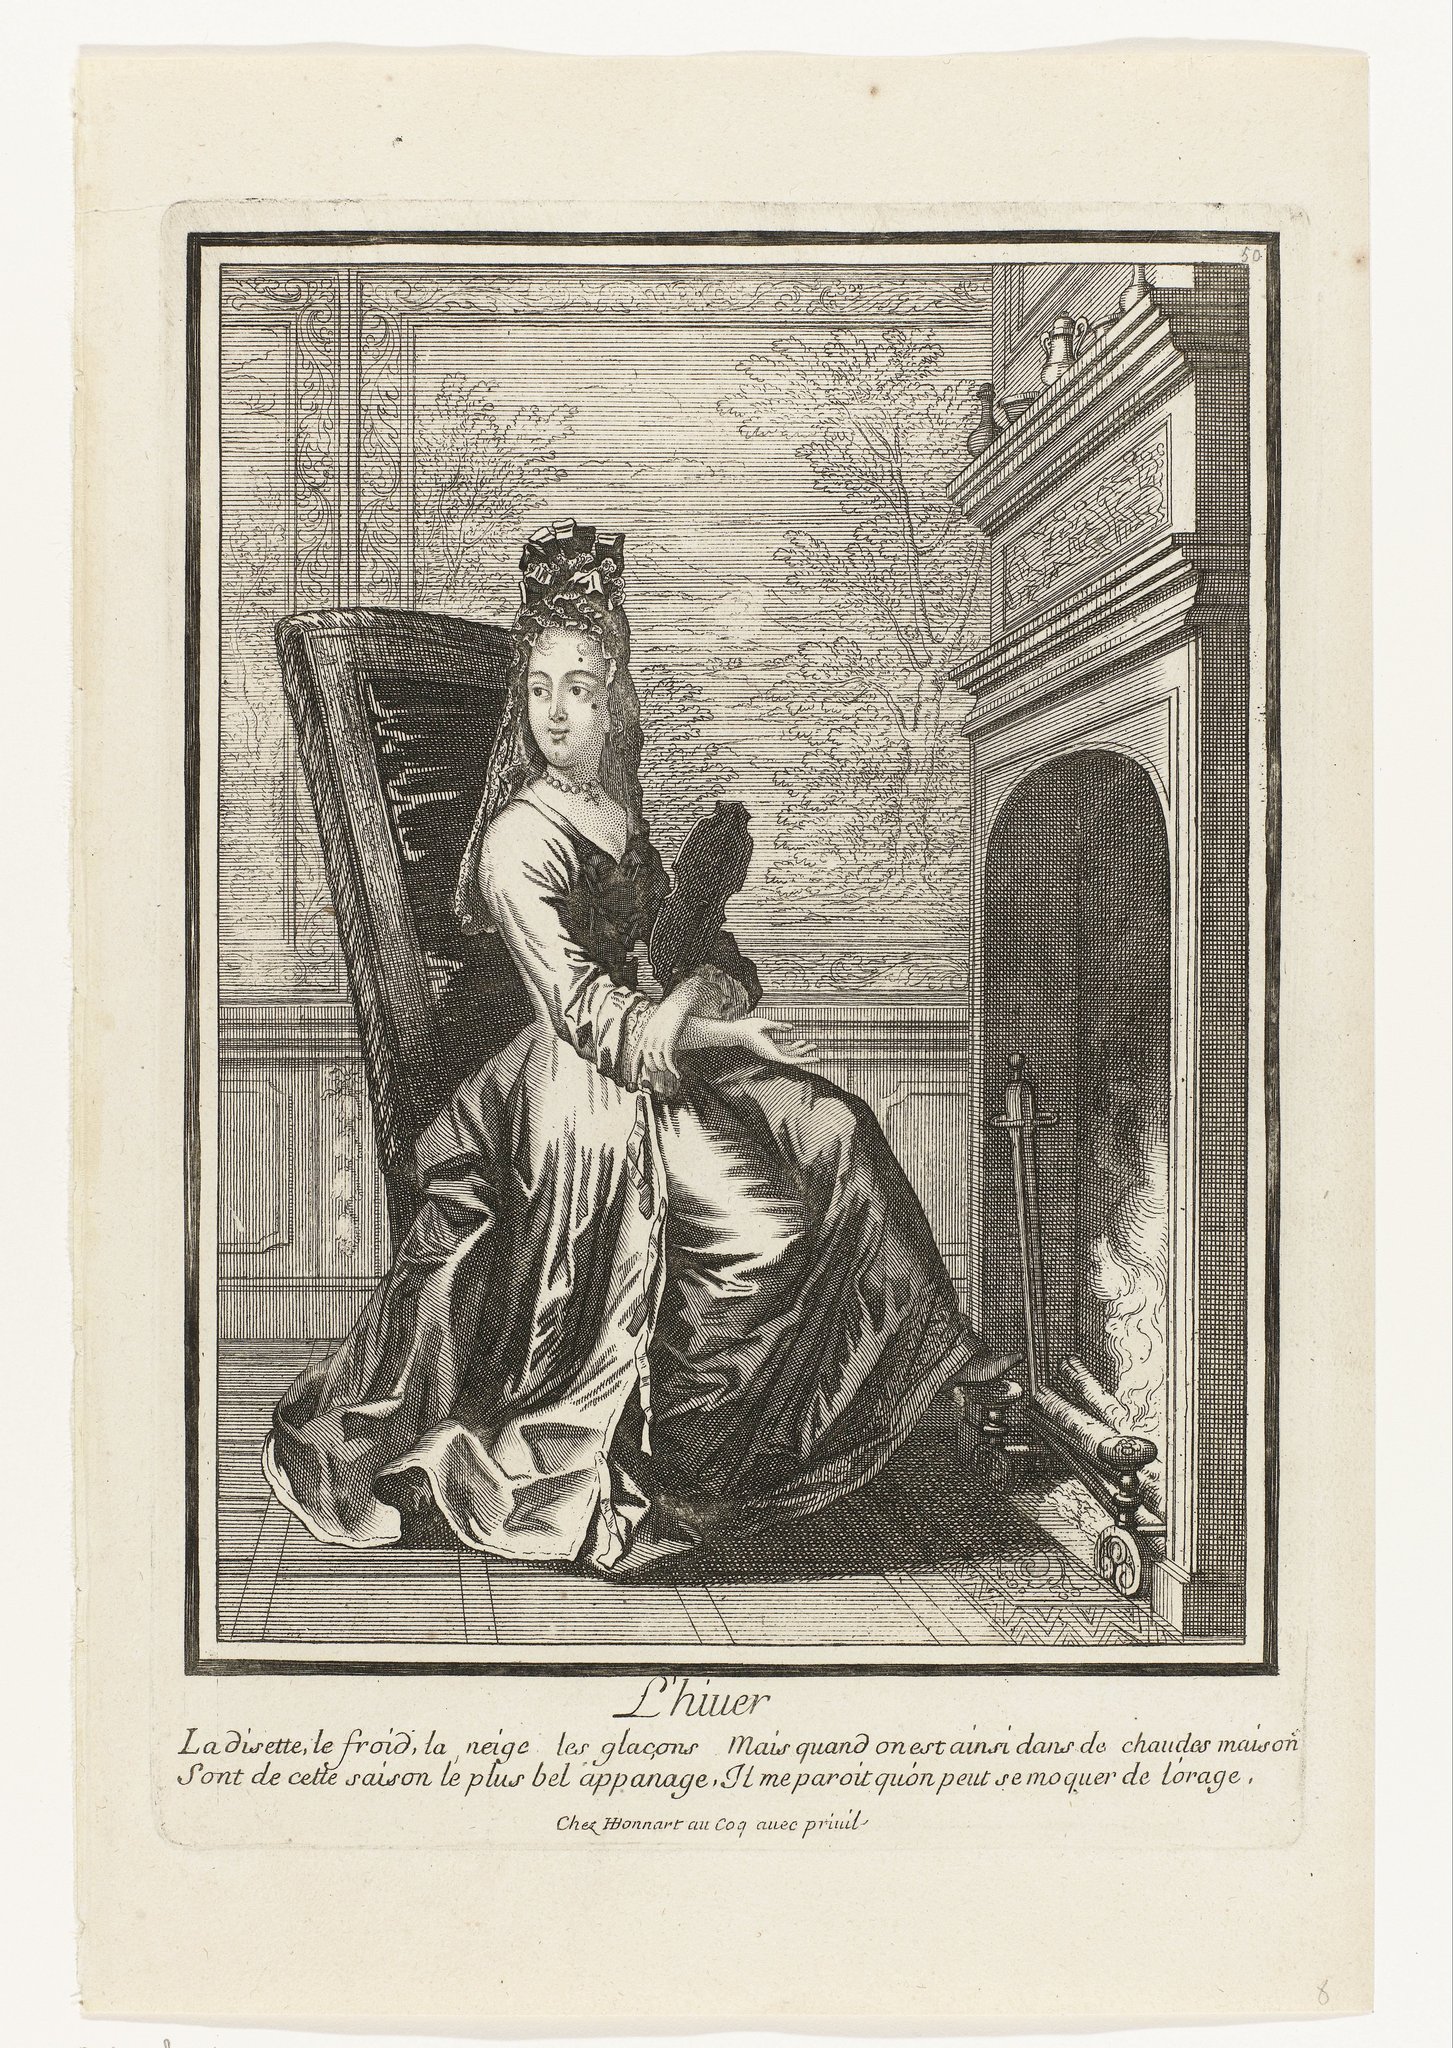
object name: print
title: Personificaties van de vier seizoenen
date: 1652-1711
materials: paper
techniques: engraving, etching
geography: france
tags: year divided into four seasons, winter, 'hyems'; 'inverno' (ripa), open hearth, fire-place, tapestry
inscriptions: collector's mark: Lugt 2228, collector's mark: Lugt 2760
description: Maakt deel uit van een vierdelige serie met personificaties van de vier seizoenen.